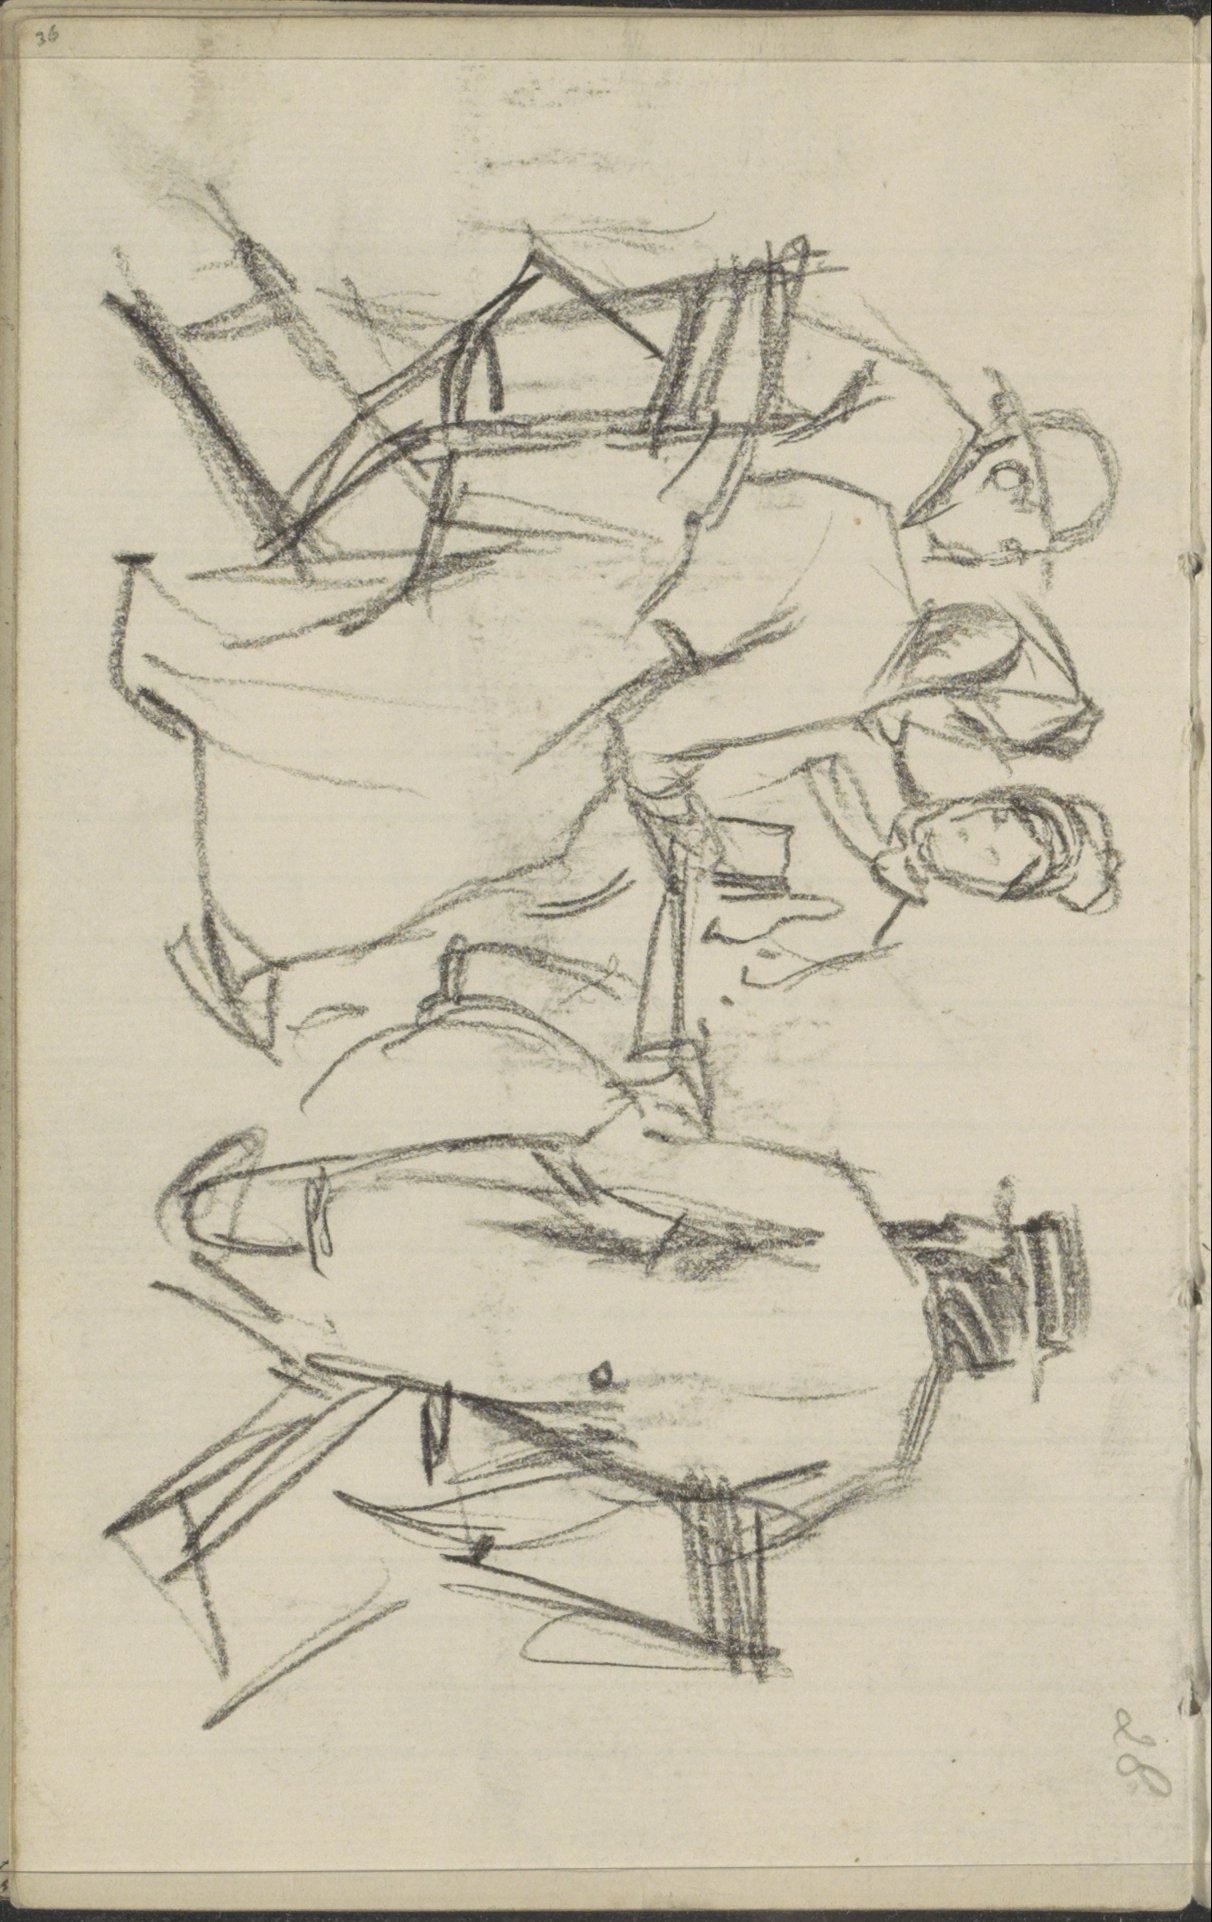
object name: sketchbook leaf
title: Twee mannen en vrouwen rondom een tafel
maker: marius bauer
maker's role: draughtsman, print maker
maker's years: 1867-1932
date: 1881-1885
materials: chalk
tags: sitting figure, adult woman, adult man, table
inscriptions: annotation: ‘28’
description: De figuren zitten op tuin- of terrasstoelen. Pagina 36 uit een schetsboek met 26 bladen.